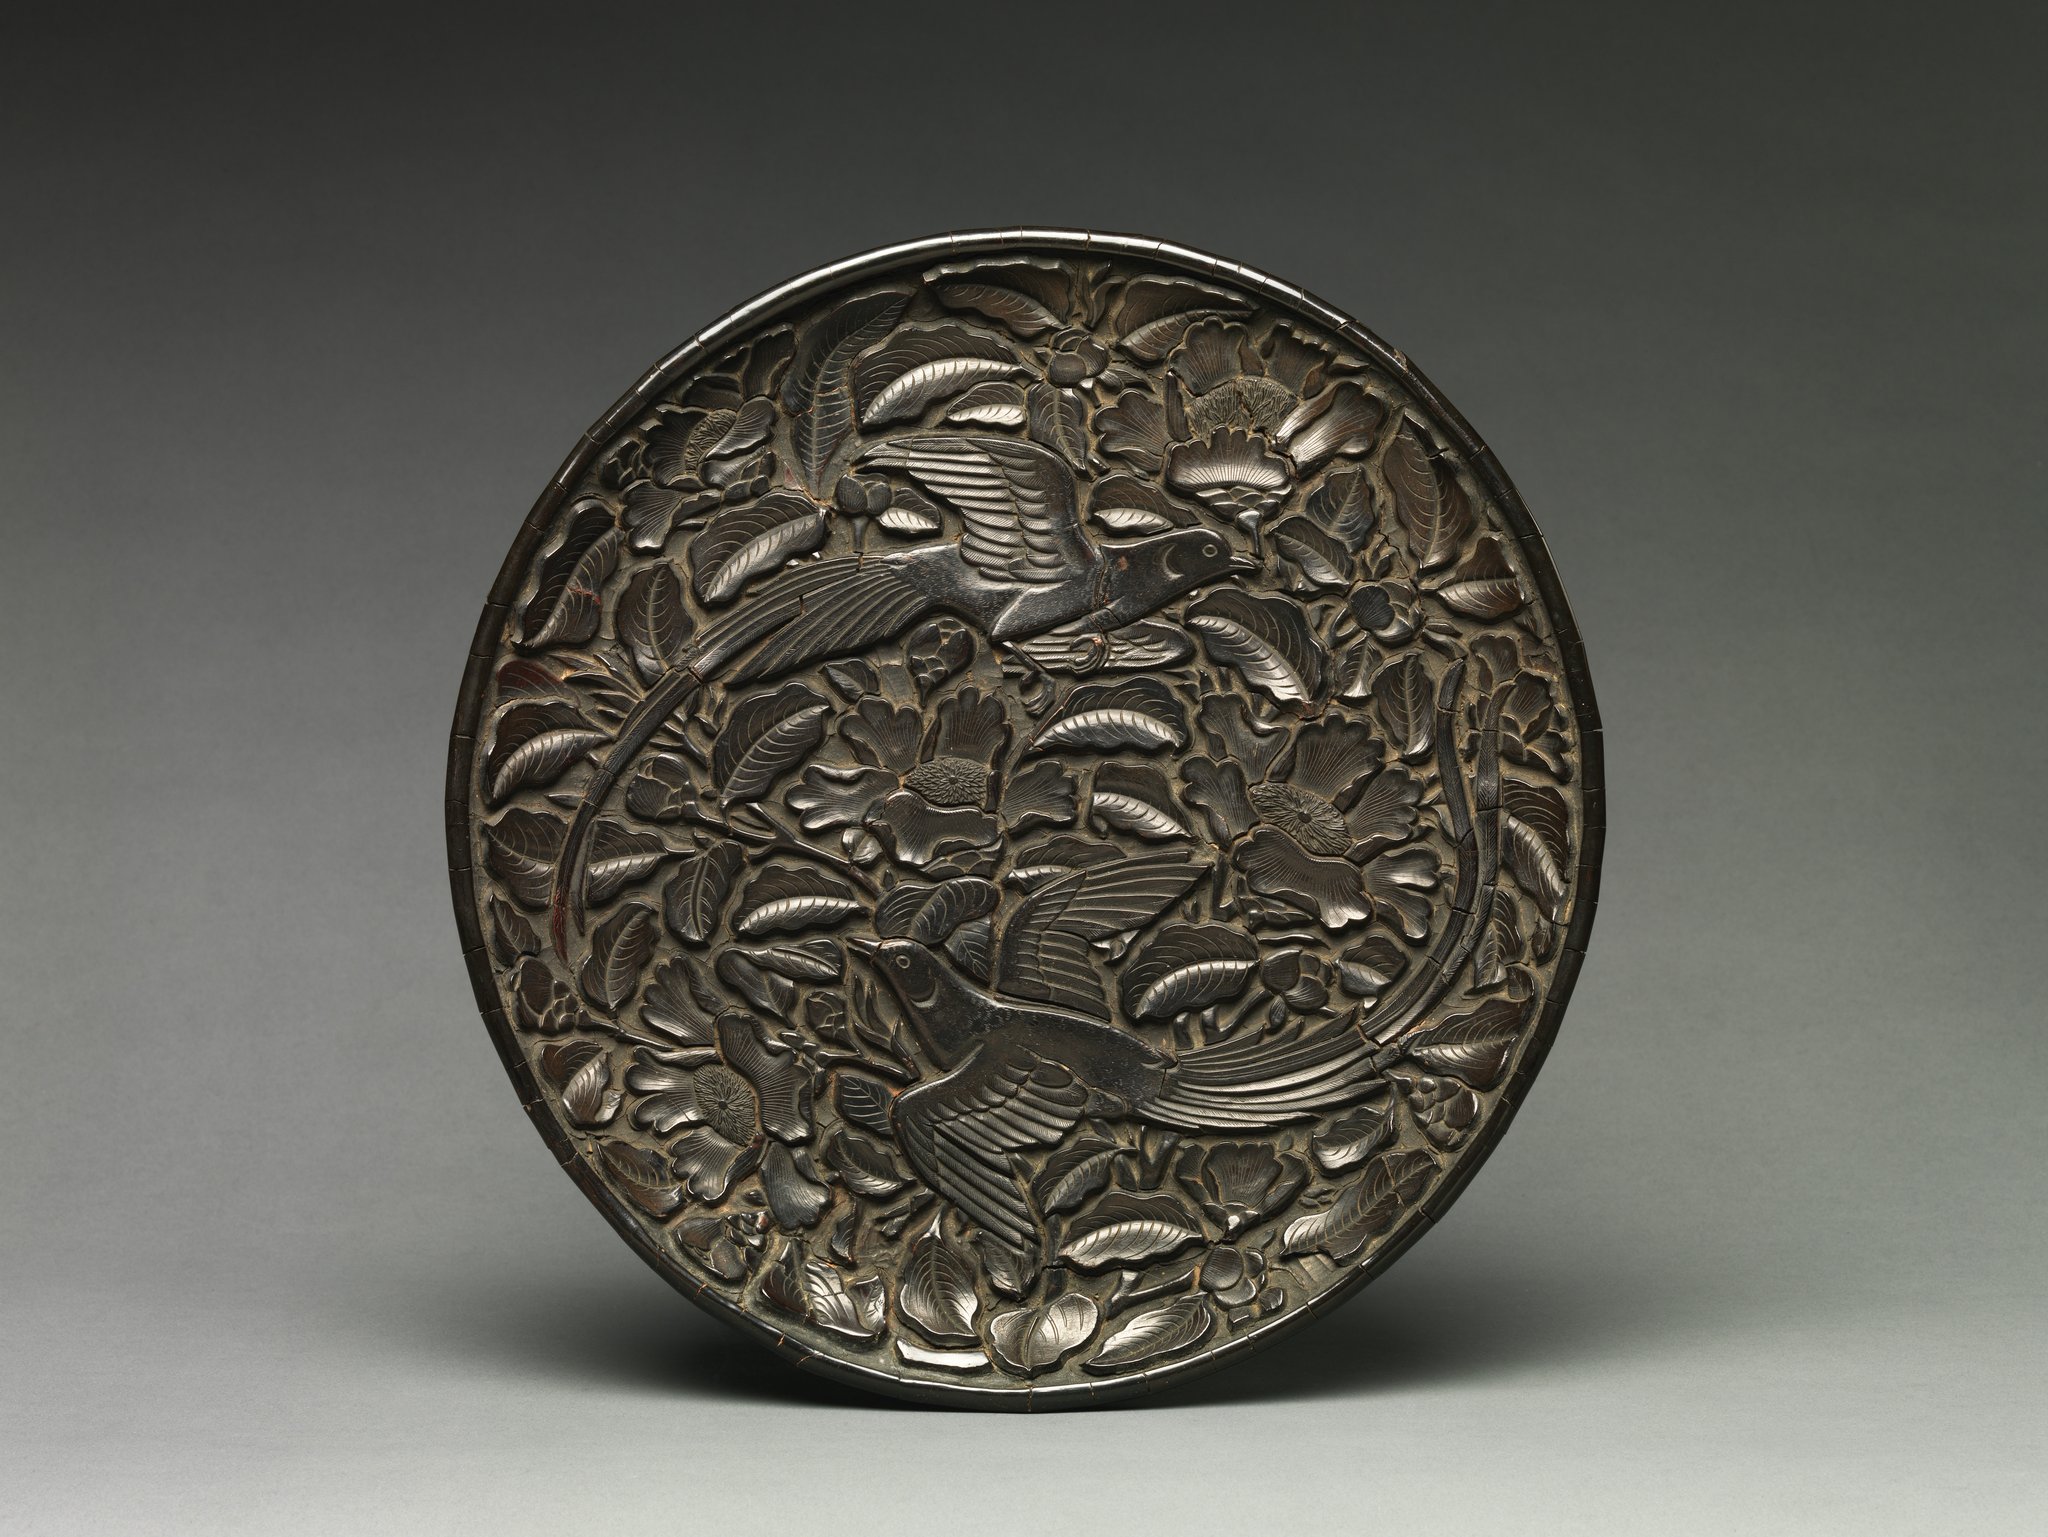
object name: dish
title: Dish with long-tailed birds and flowers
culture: chinese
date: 1351-1400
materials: lacquer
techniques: carving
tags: birds,flowers